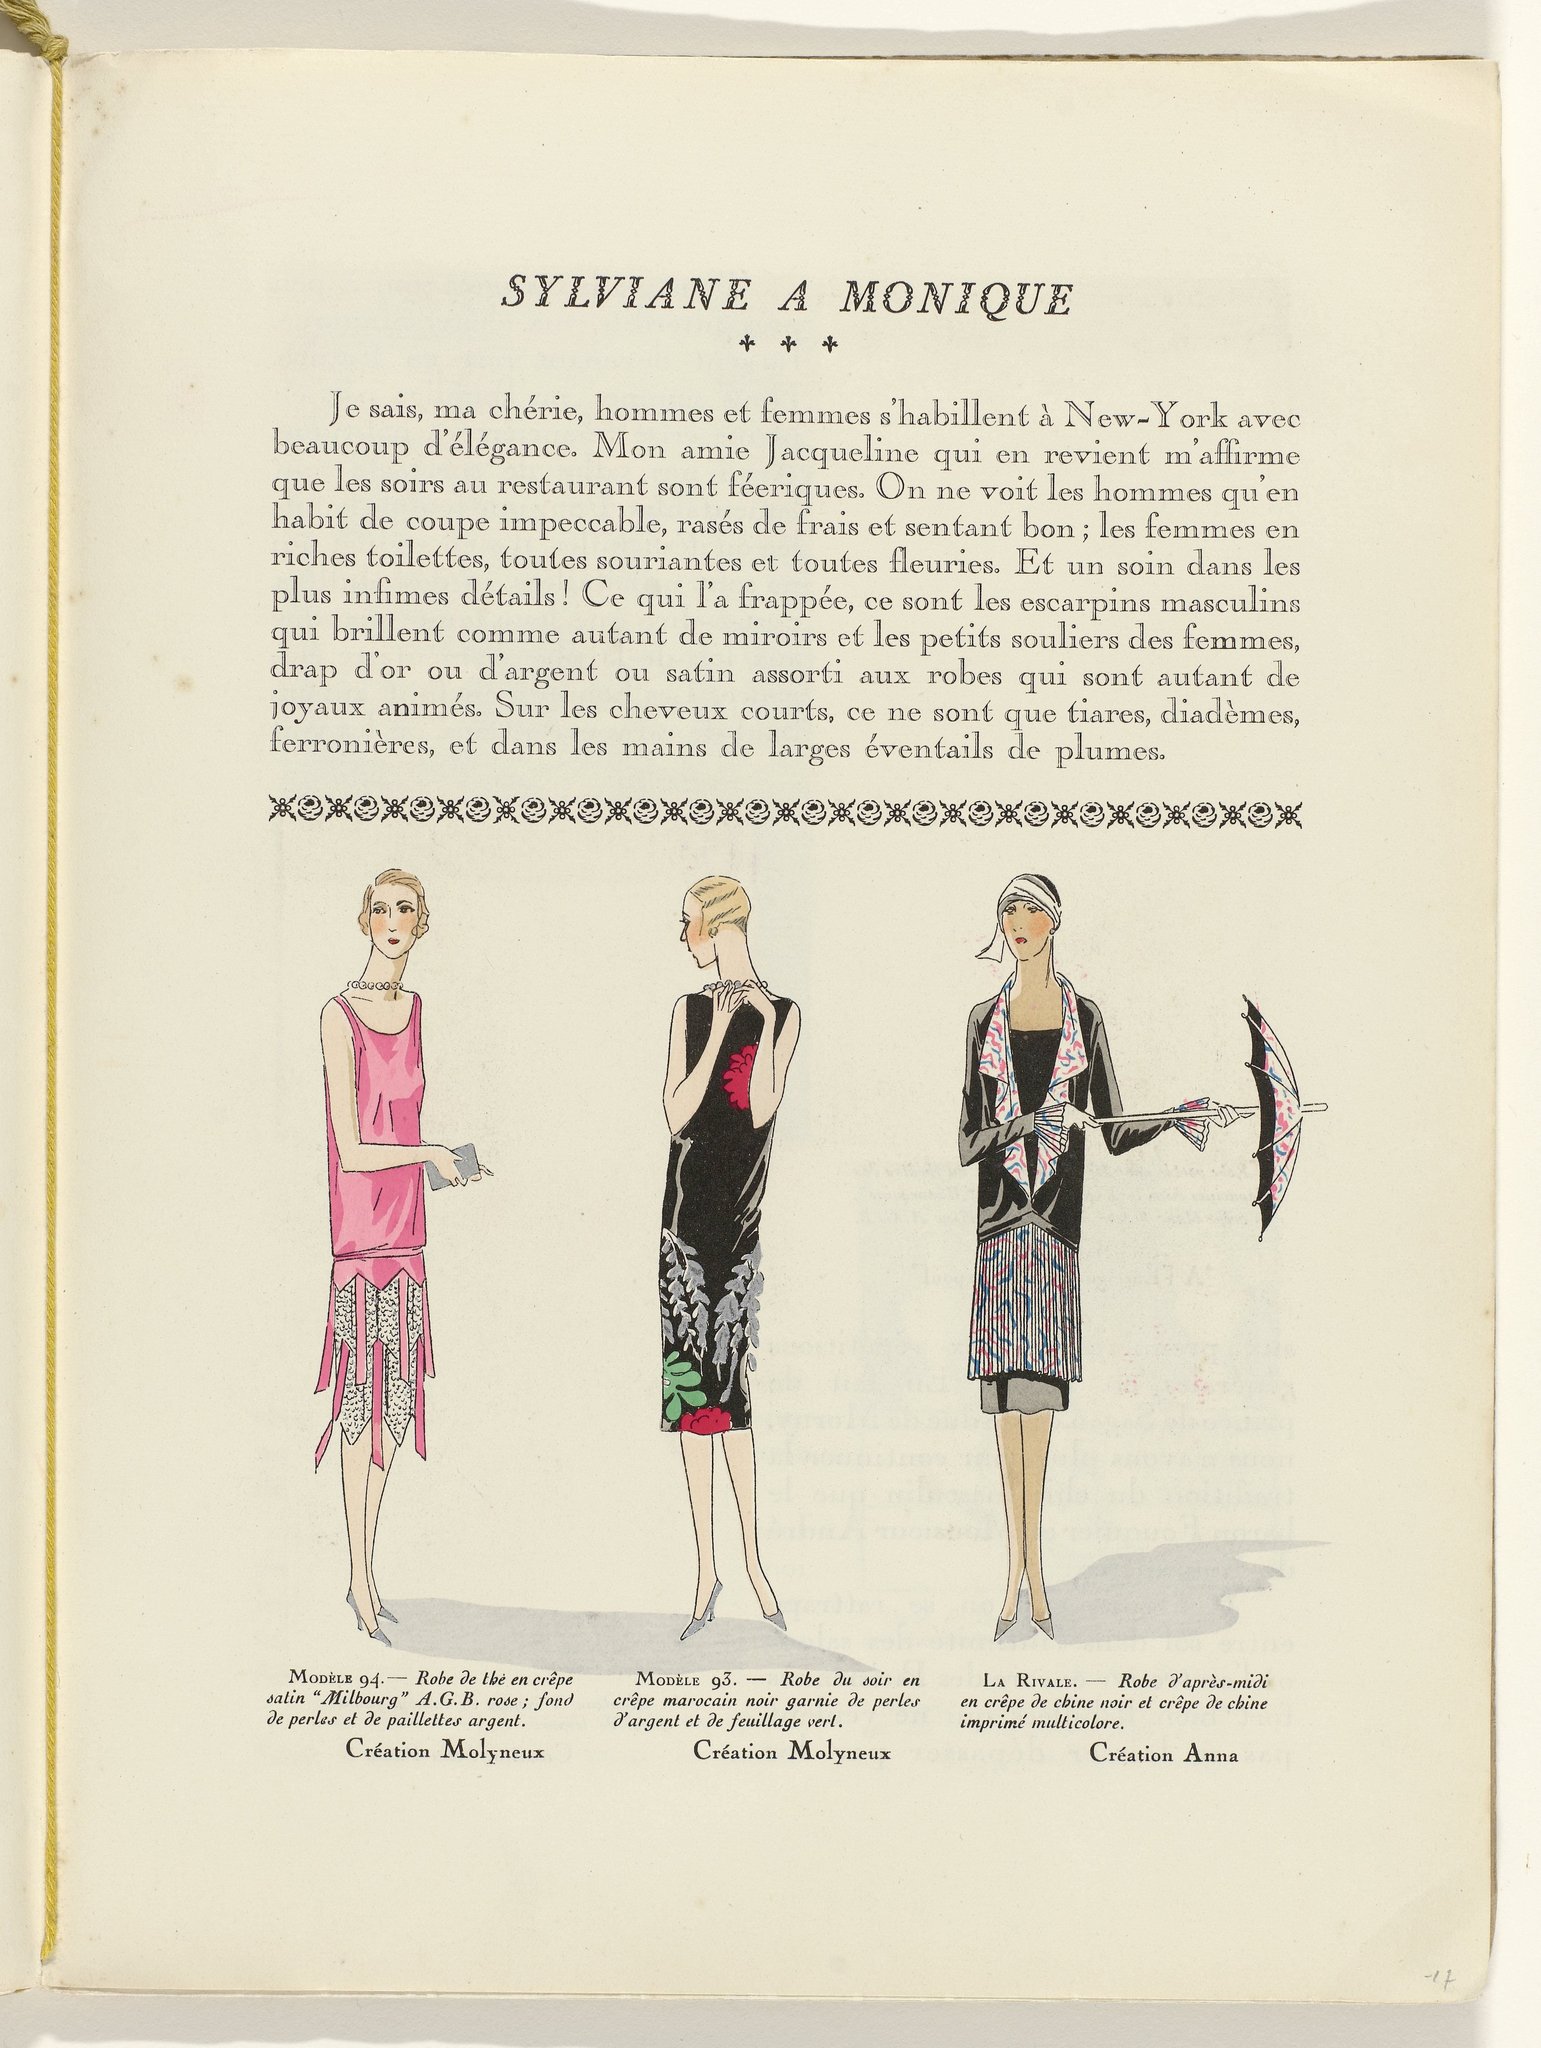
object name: fashion print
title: Art - Goût - Beauté, Feuillets de l' élégance féminine, Février 1926, No. 66, 6e Année, p. 17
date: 1926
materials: paper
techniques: brush, hand coloring, lithograph, pochoir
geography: paris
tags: dress, gown: evening dress (+ women's clothes), dress, gown: day dress (+ women's clothes), dress, gown (tea-gown) (+ women's clothes), fashion plates, parasol, sunshade (+ women's clothes)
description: Tekst 'Sylviane a monique' met een afbeelding van drie vrouwen. Links: 'robe de thé' van Molyneux. Midden: avondjurk van zwarte crêpe marocain van Molyneux. Rechts: middagjapon van zwarte 'crêpe de chine' van Anna. Pagina uit het modetijdschrift Art-Goût-Beauté (1920-1933).